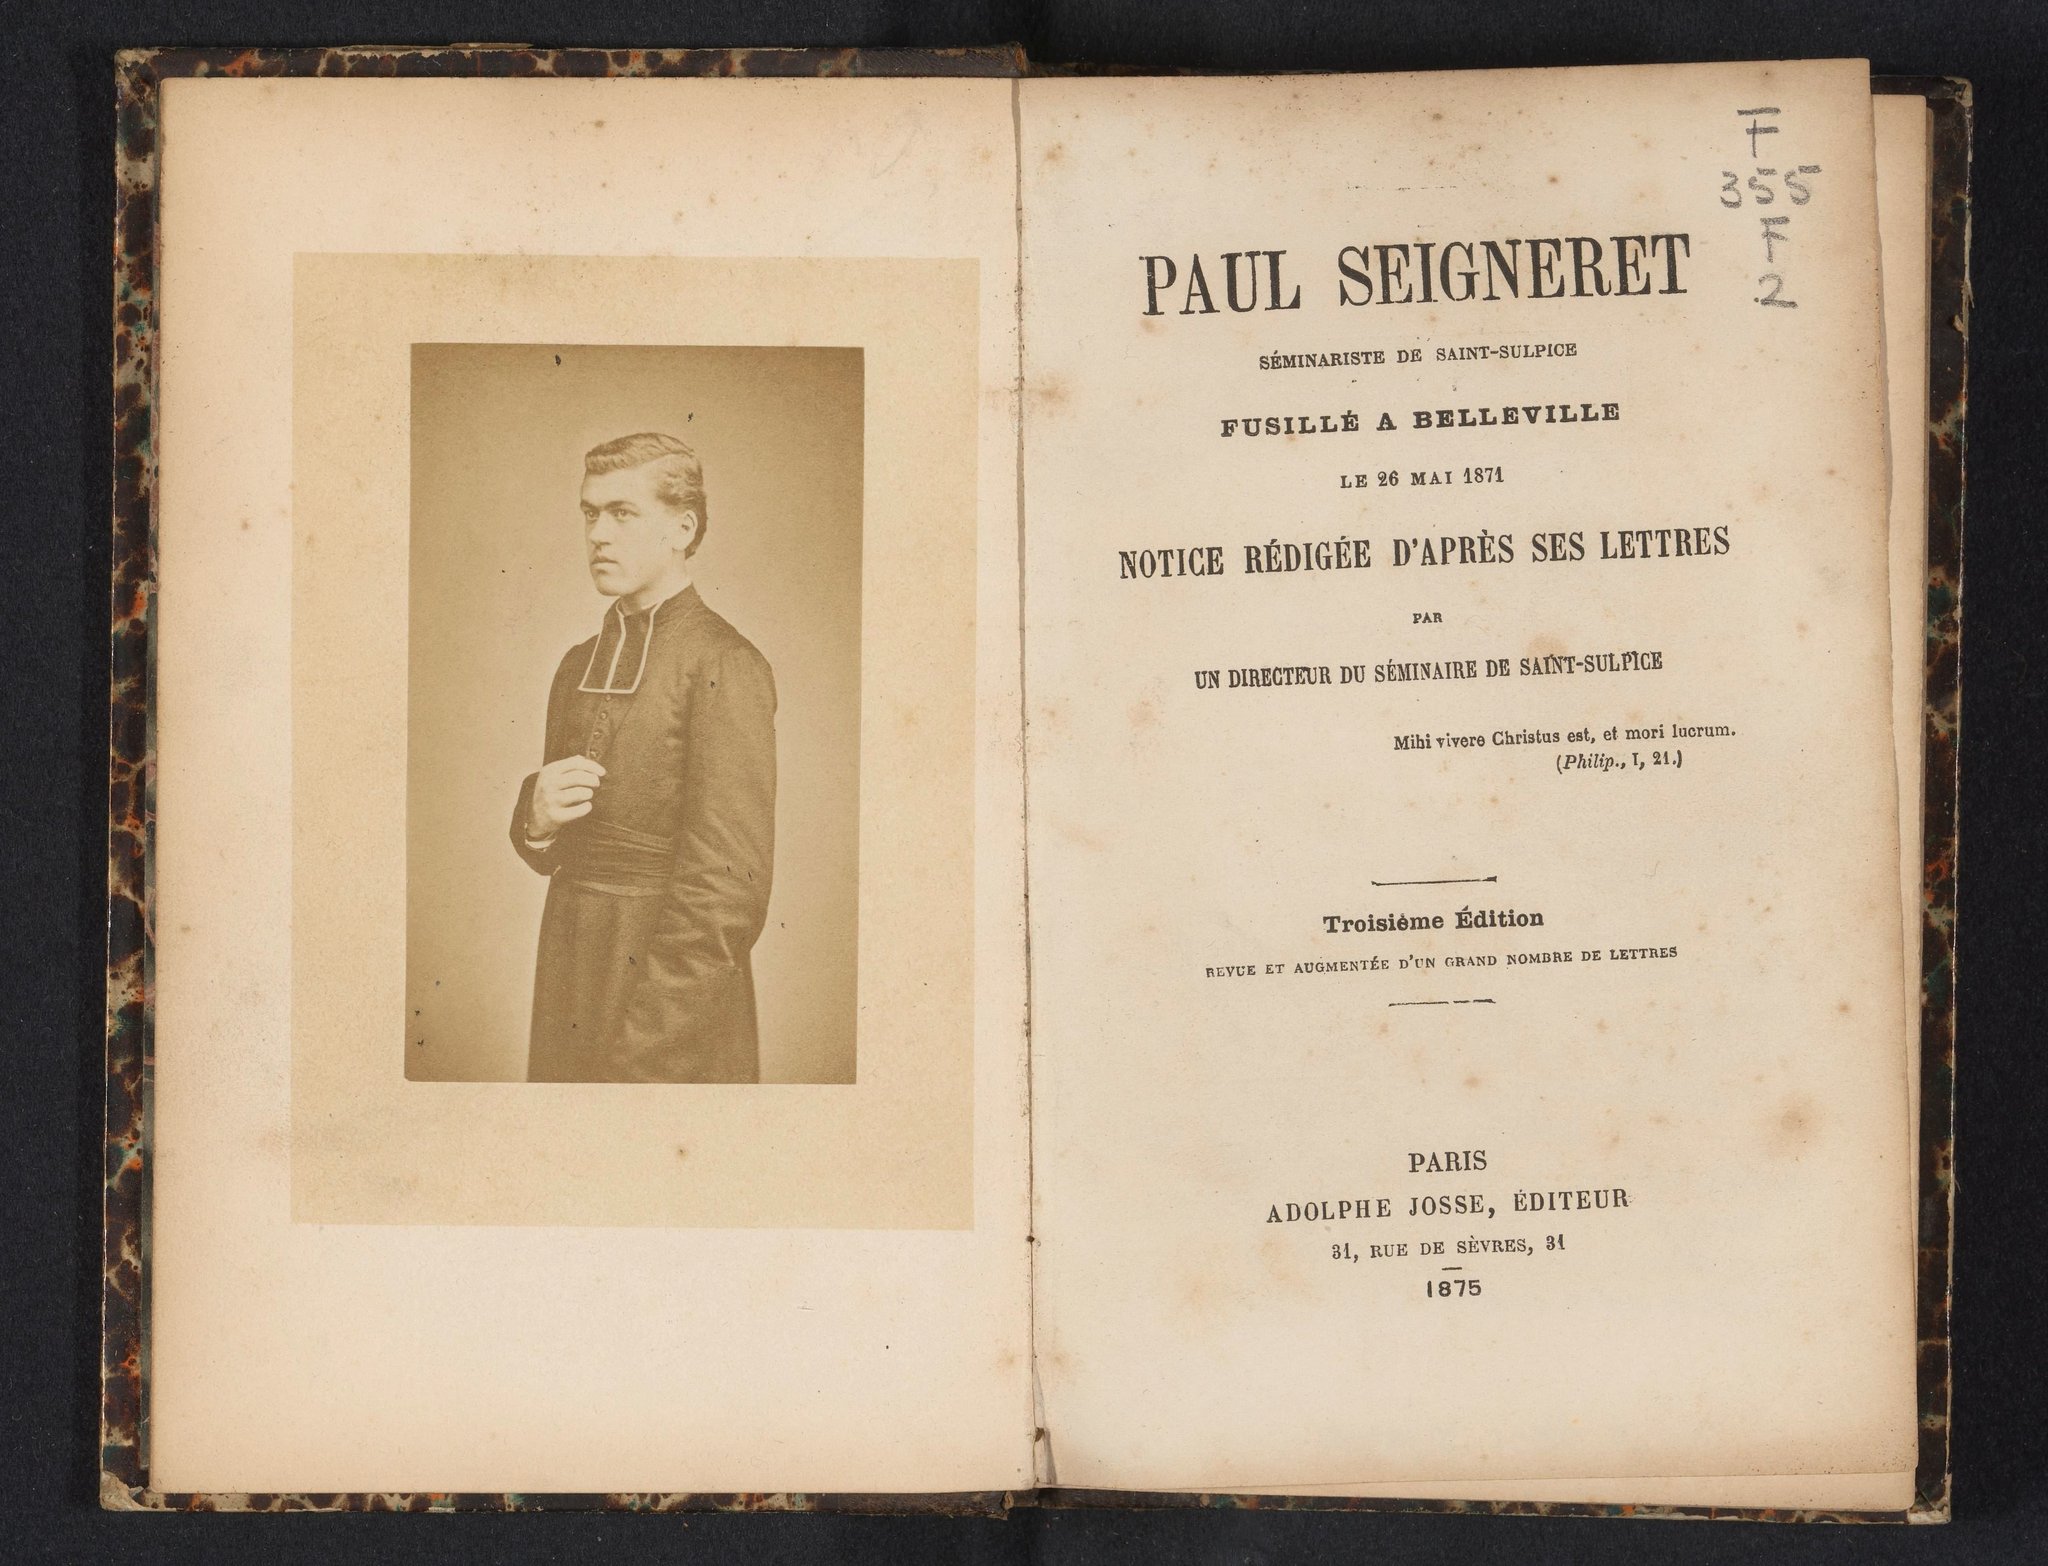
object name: photograph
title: Portret van Paul Seigneret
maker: Anonymous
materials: photographic support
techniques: albumen print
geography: france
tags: priest, priest (roman catholic)